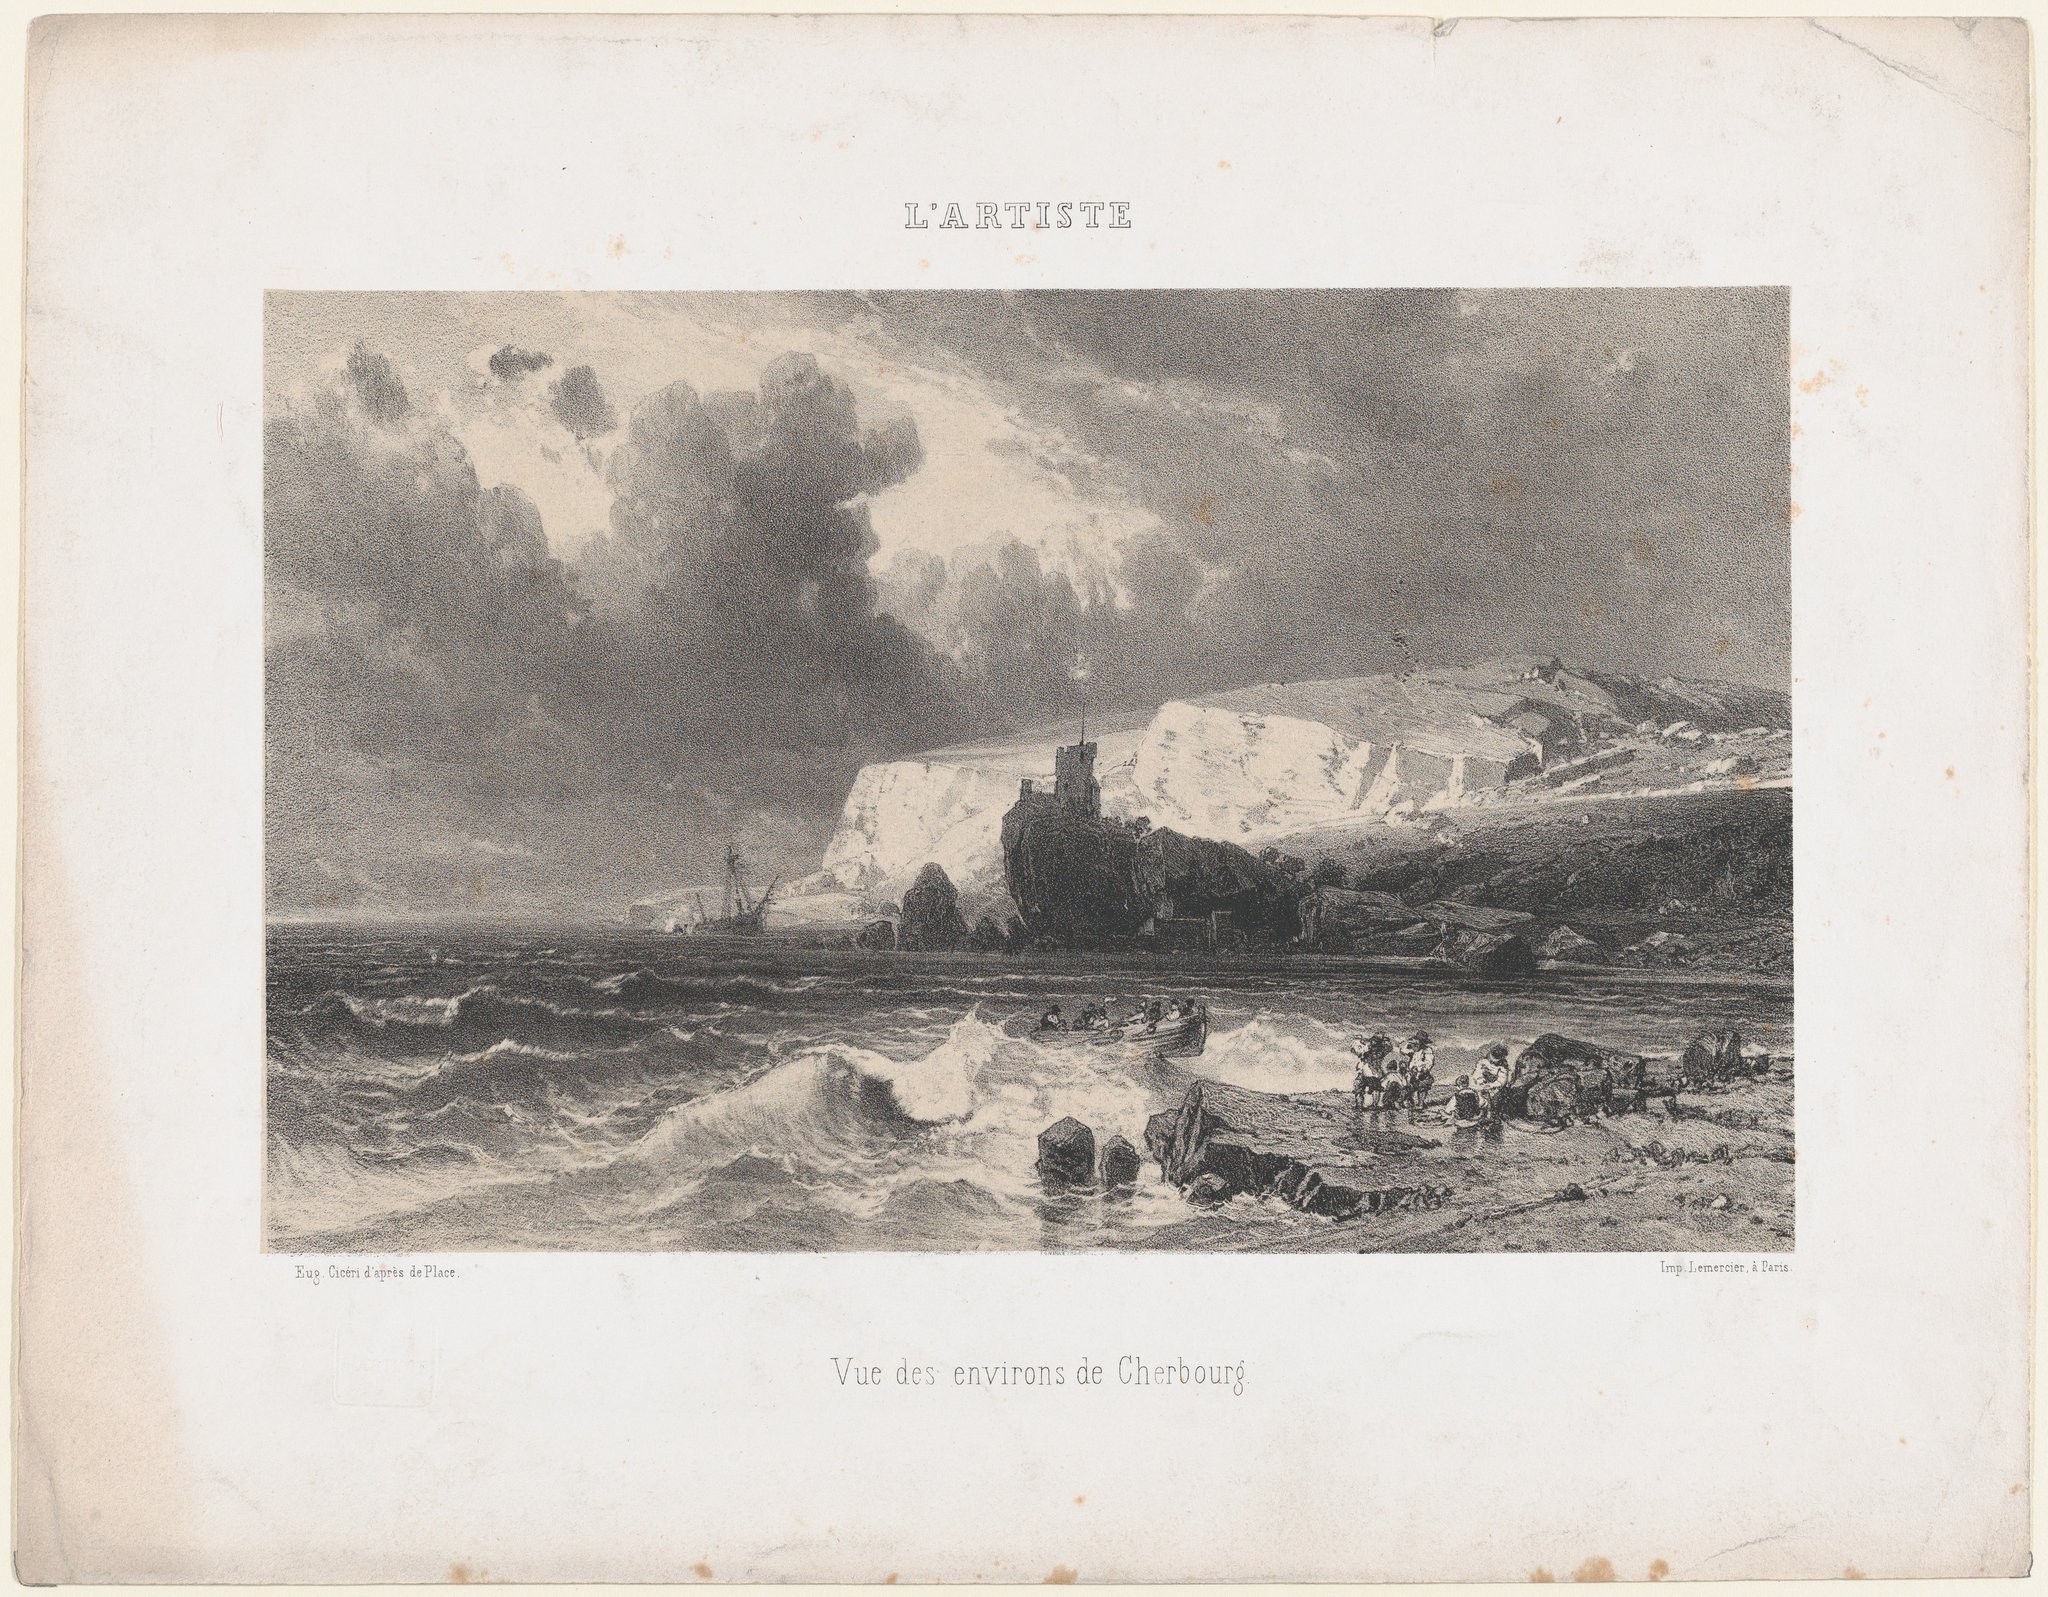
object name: print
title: View near Cherbourg, from "L'Artiste"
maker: eugène cicéri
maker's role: artist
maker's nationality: french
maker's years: 1813-1890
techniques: printmaking, lithograph